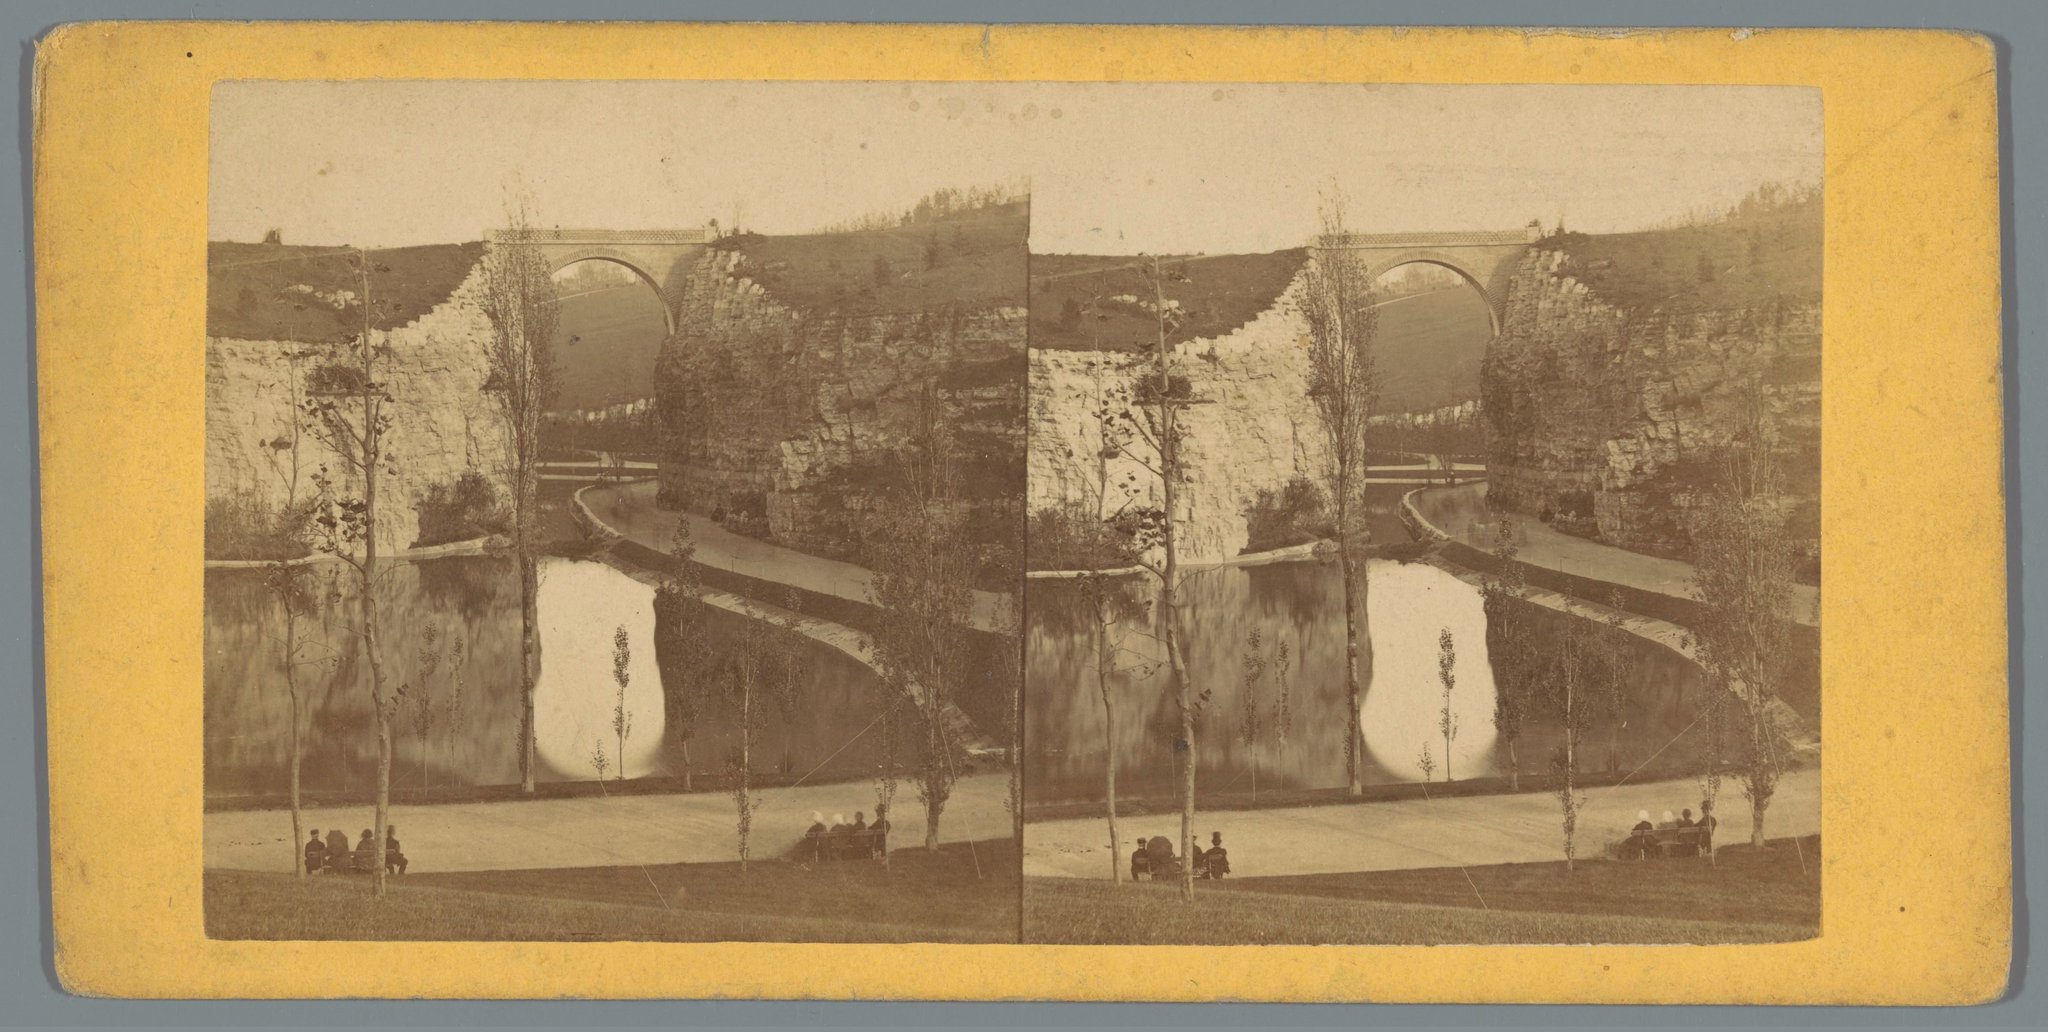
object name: stereograph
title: Gezicht op een brug in het Parc des Buttes-Chaumont in Parijs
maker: Anonymous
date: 1850-1880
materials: cardboard, photographic support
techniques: albumen print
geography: parc des buttes-chaumont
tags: bridge, public gardens, park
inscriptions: inscription: ‘Buttes-Chaumont’, number: ‘69’